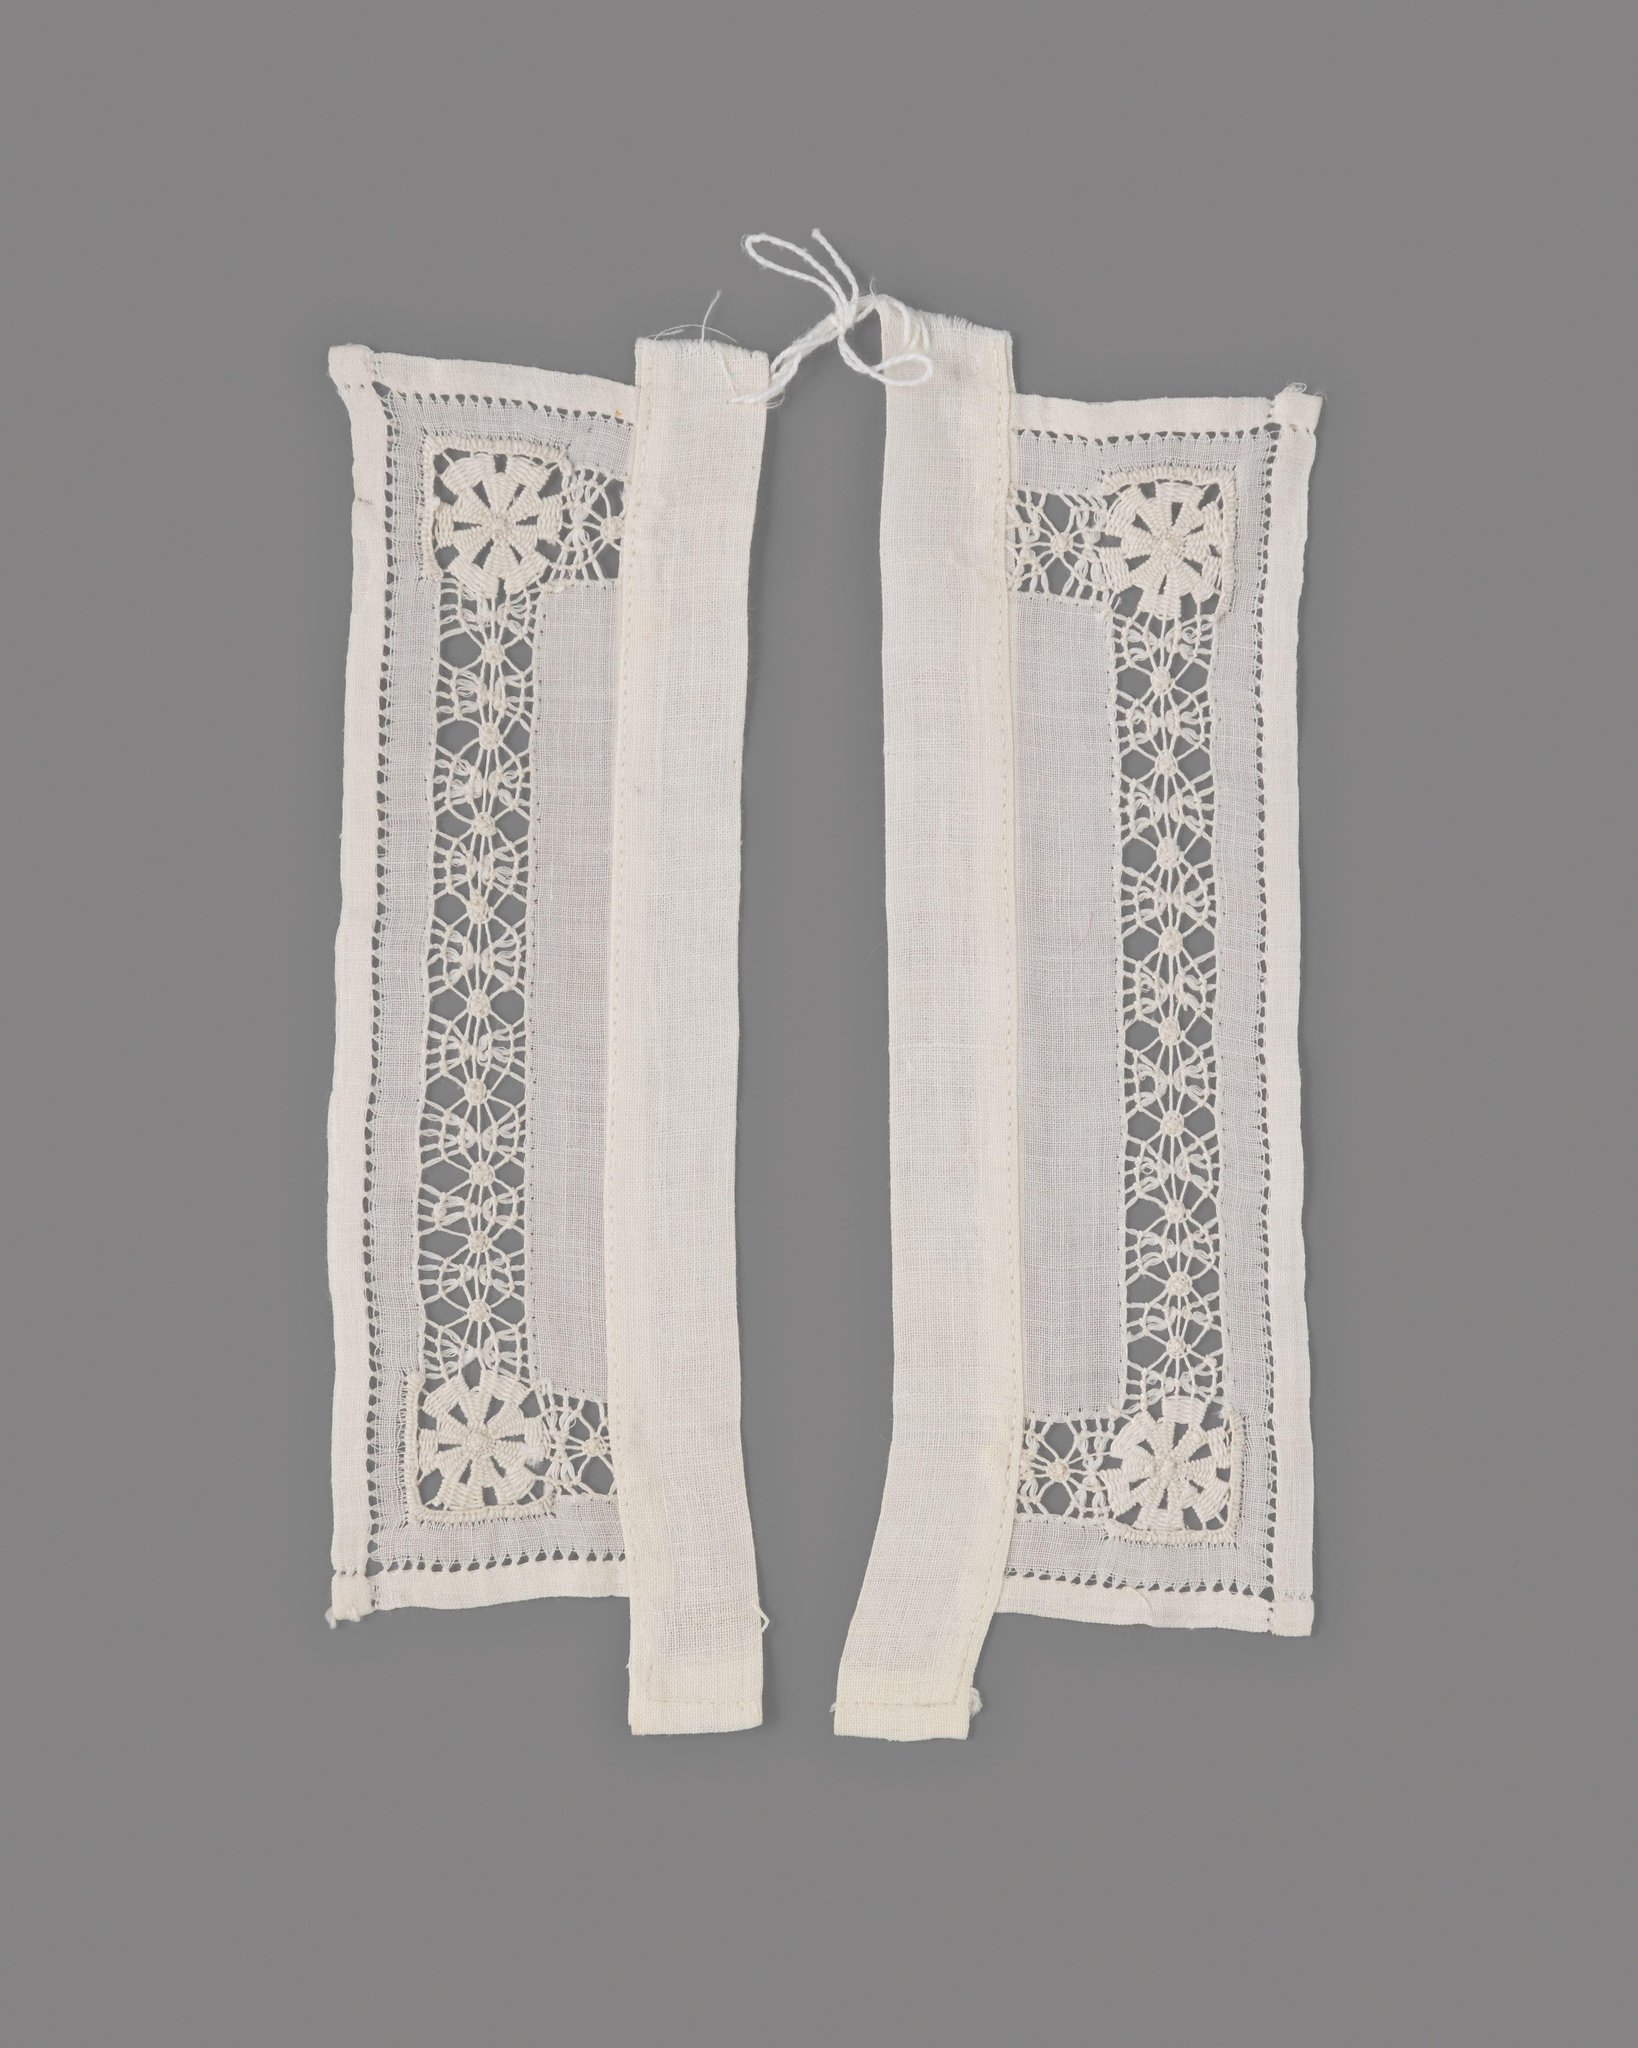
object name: cuff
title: Manchet met rand naaldweefsel of knoopwerk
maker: Anonymous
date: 1850-1920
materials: linen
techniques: sewing, weave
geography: western europe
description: Manchet met rand naaldweefsel of knoopwerk.